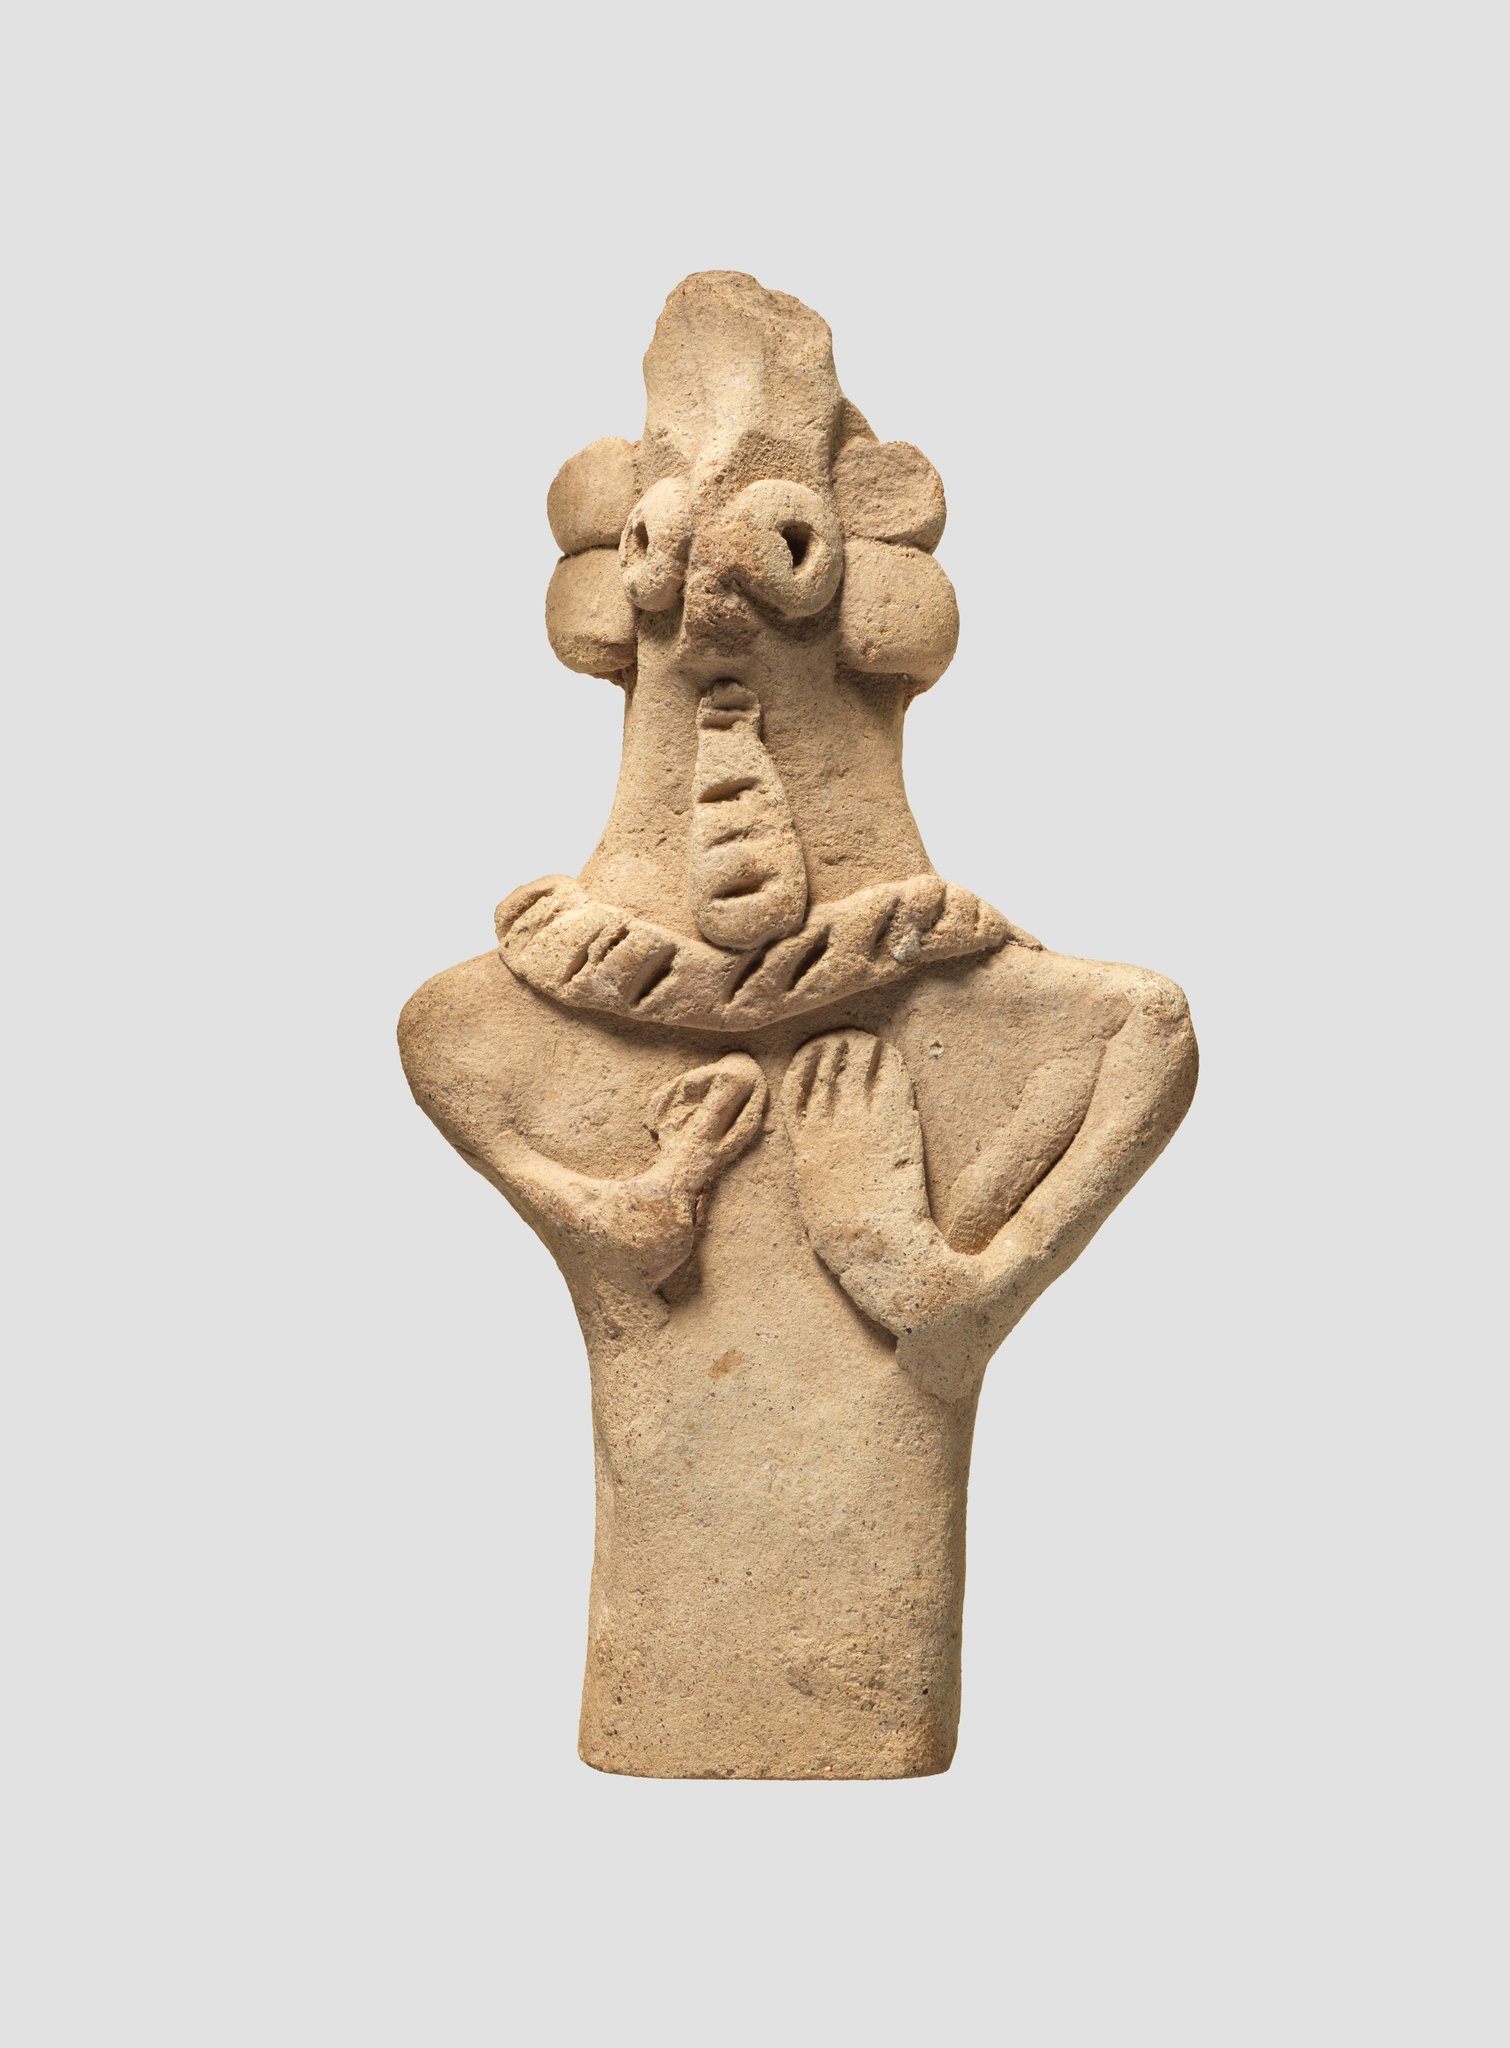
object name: sculpture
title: Figurine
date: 2350-2150 BCE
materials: ceramic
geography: syria